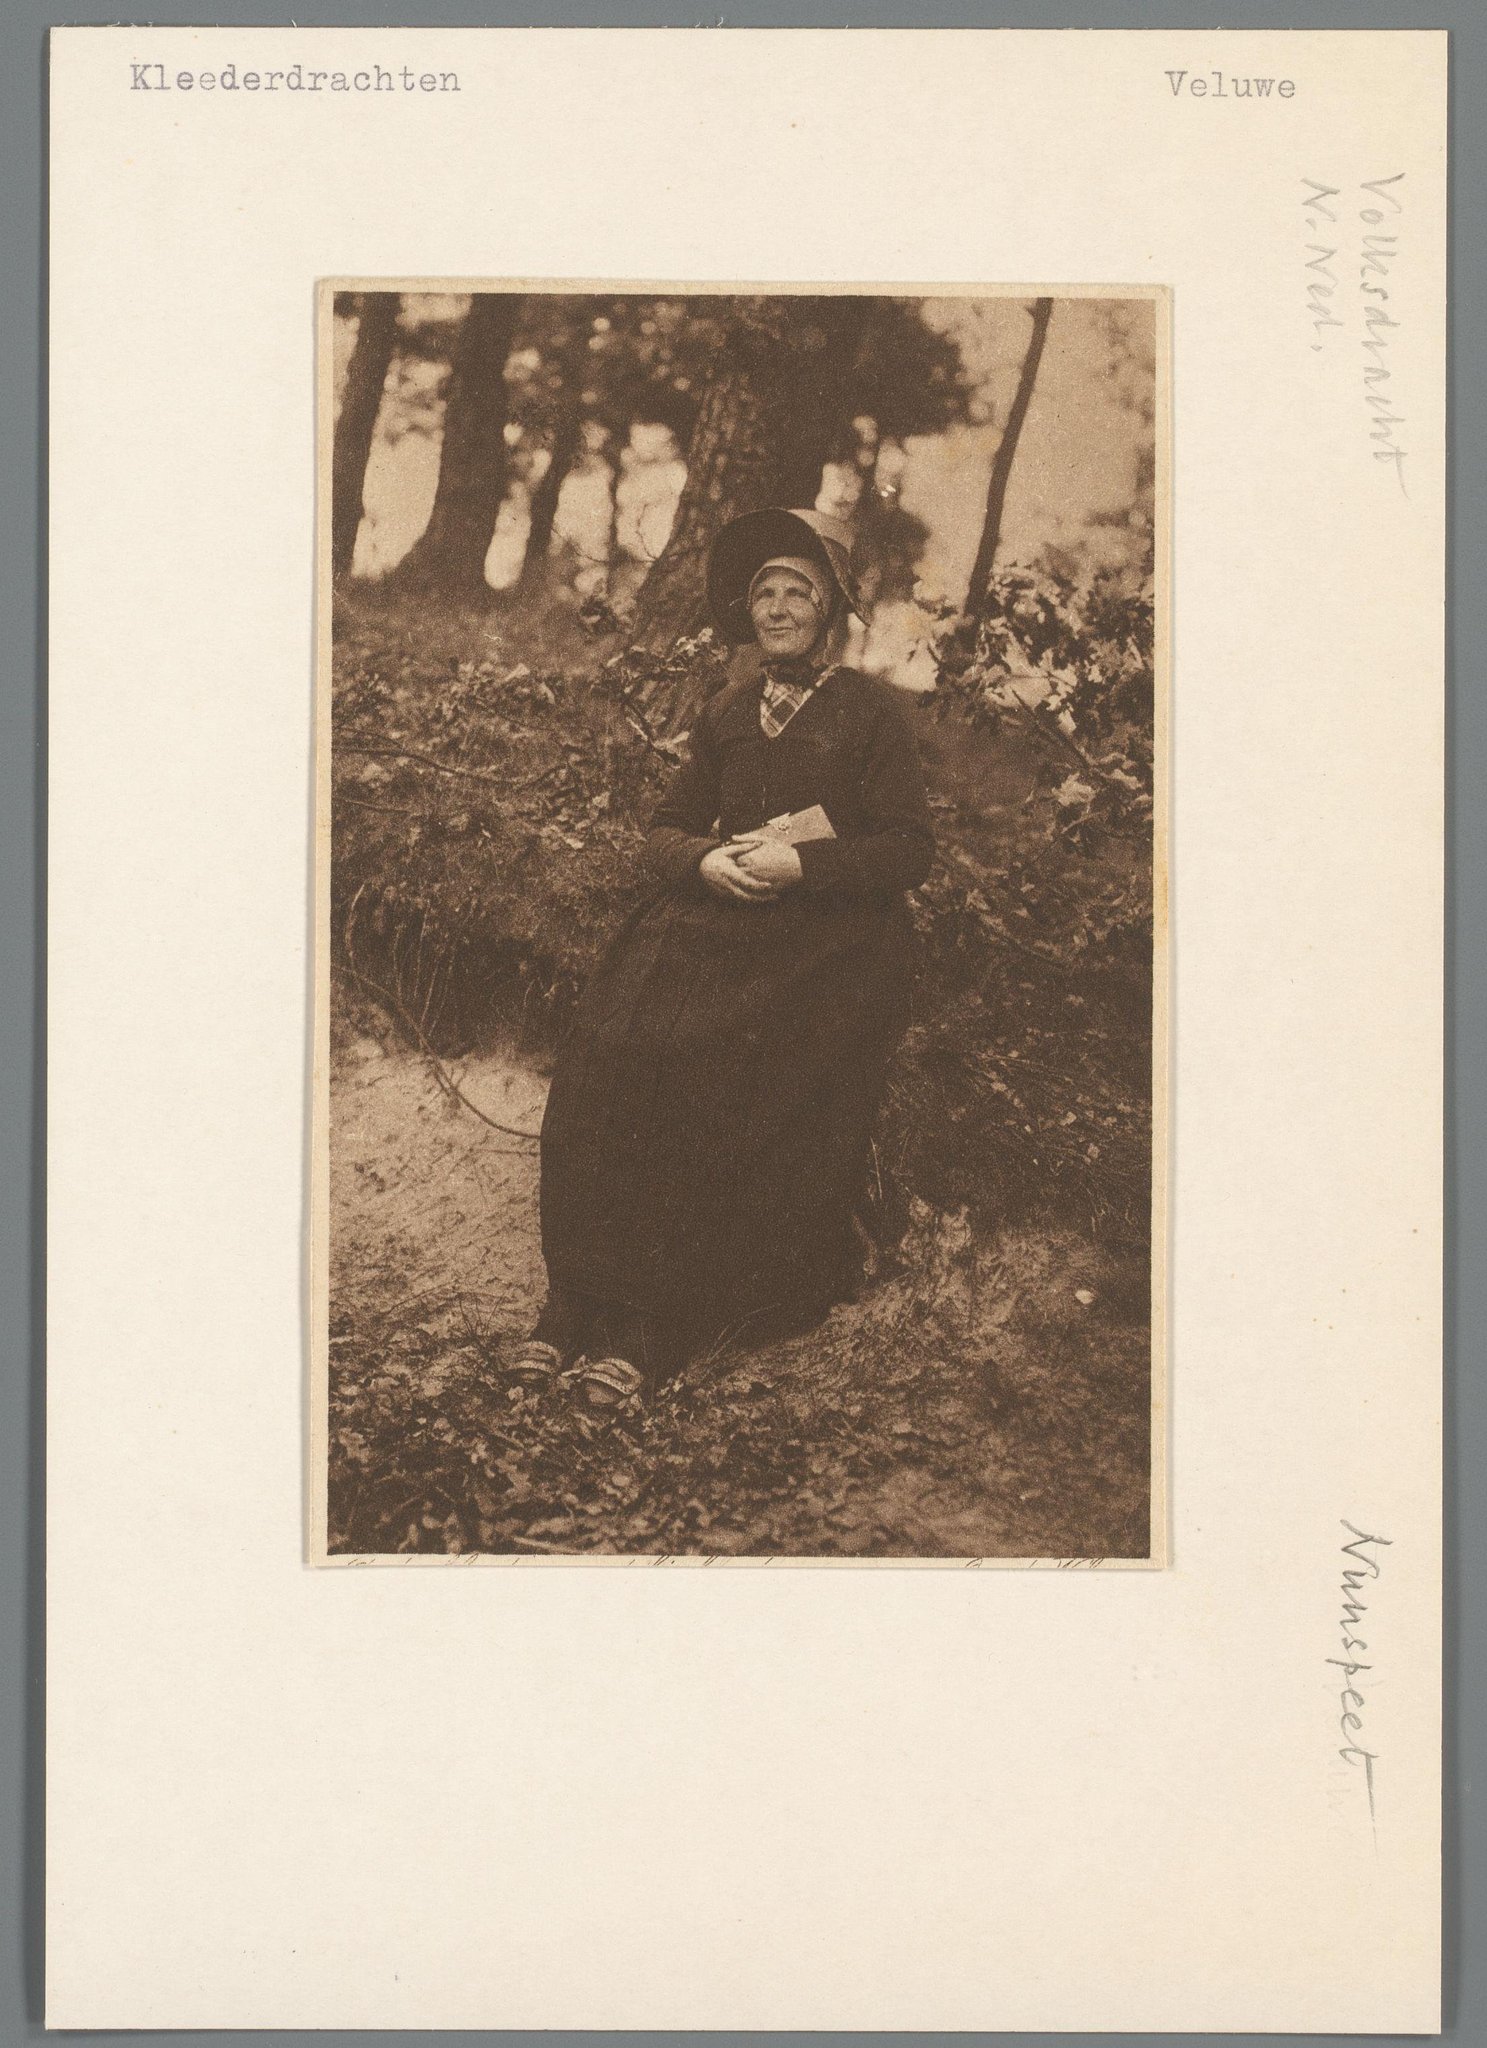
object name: photomechanical print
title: Kleederdrachten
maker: Anonymous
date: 1905-1920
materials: paper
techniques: photograph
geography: nunspeet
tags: historical persons - bb - woman, forest, wood, folk costume, regional costume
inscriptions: inscription: ‘Oude kleeding met kiphoed’, inscription: ‘Volksdracht/ N.Ned./ Nunspeet’, number: ‘34.010’, number: ‘-527000’